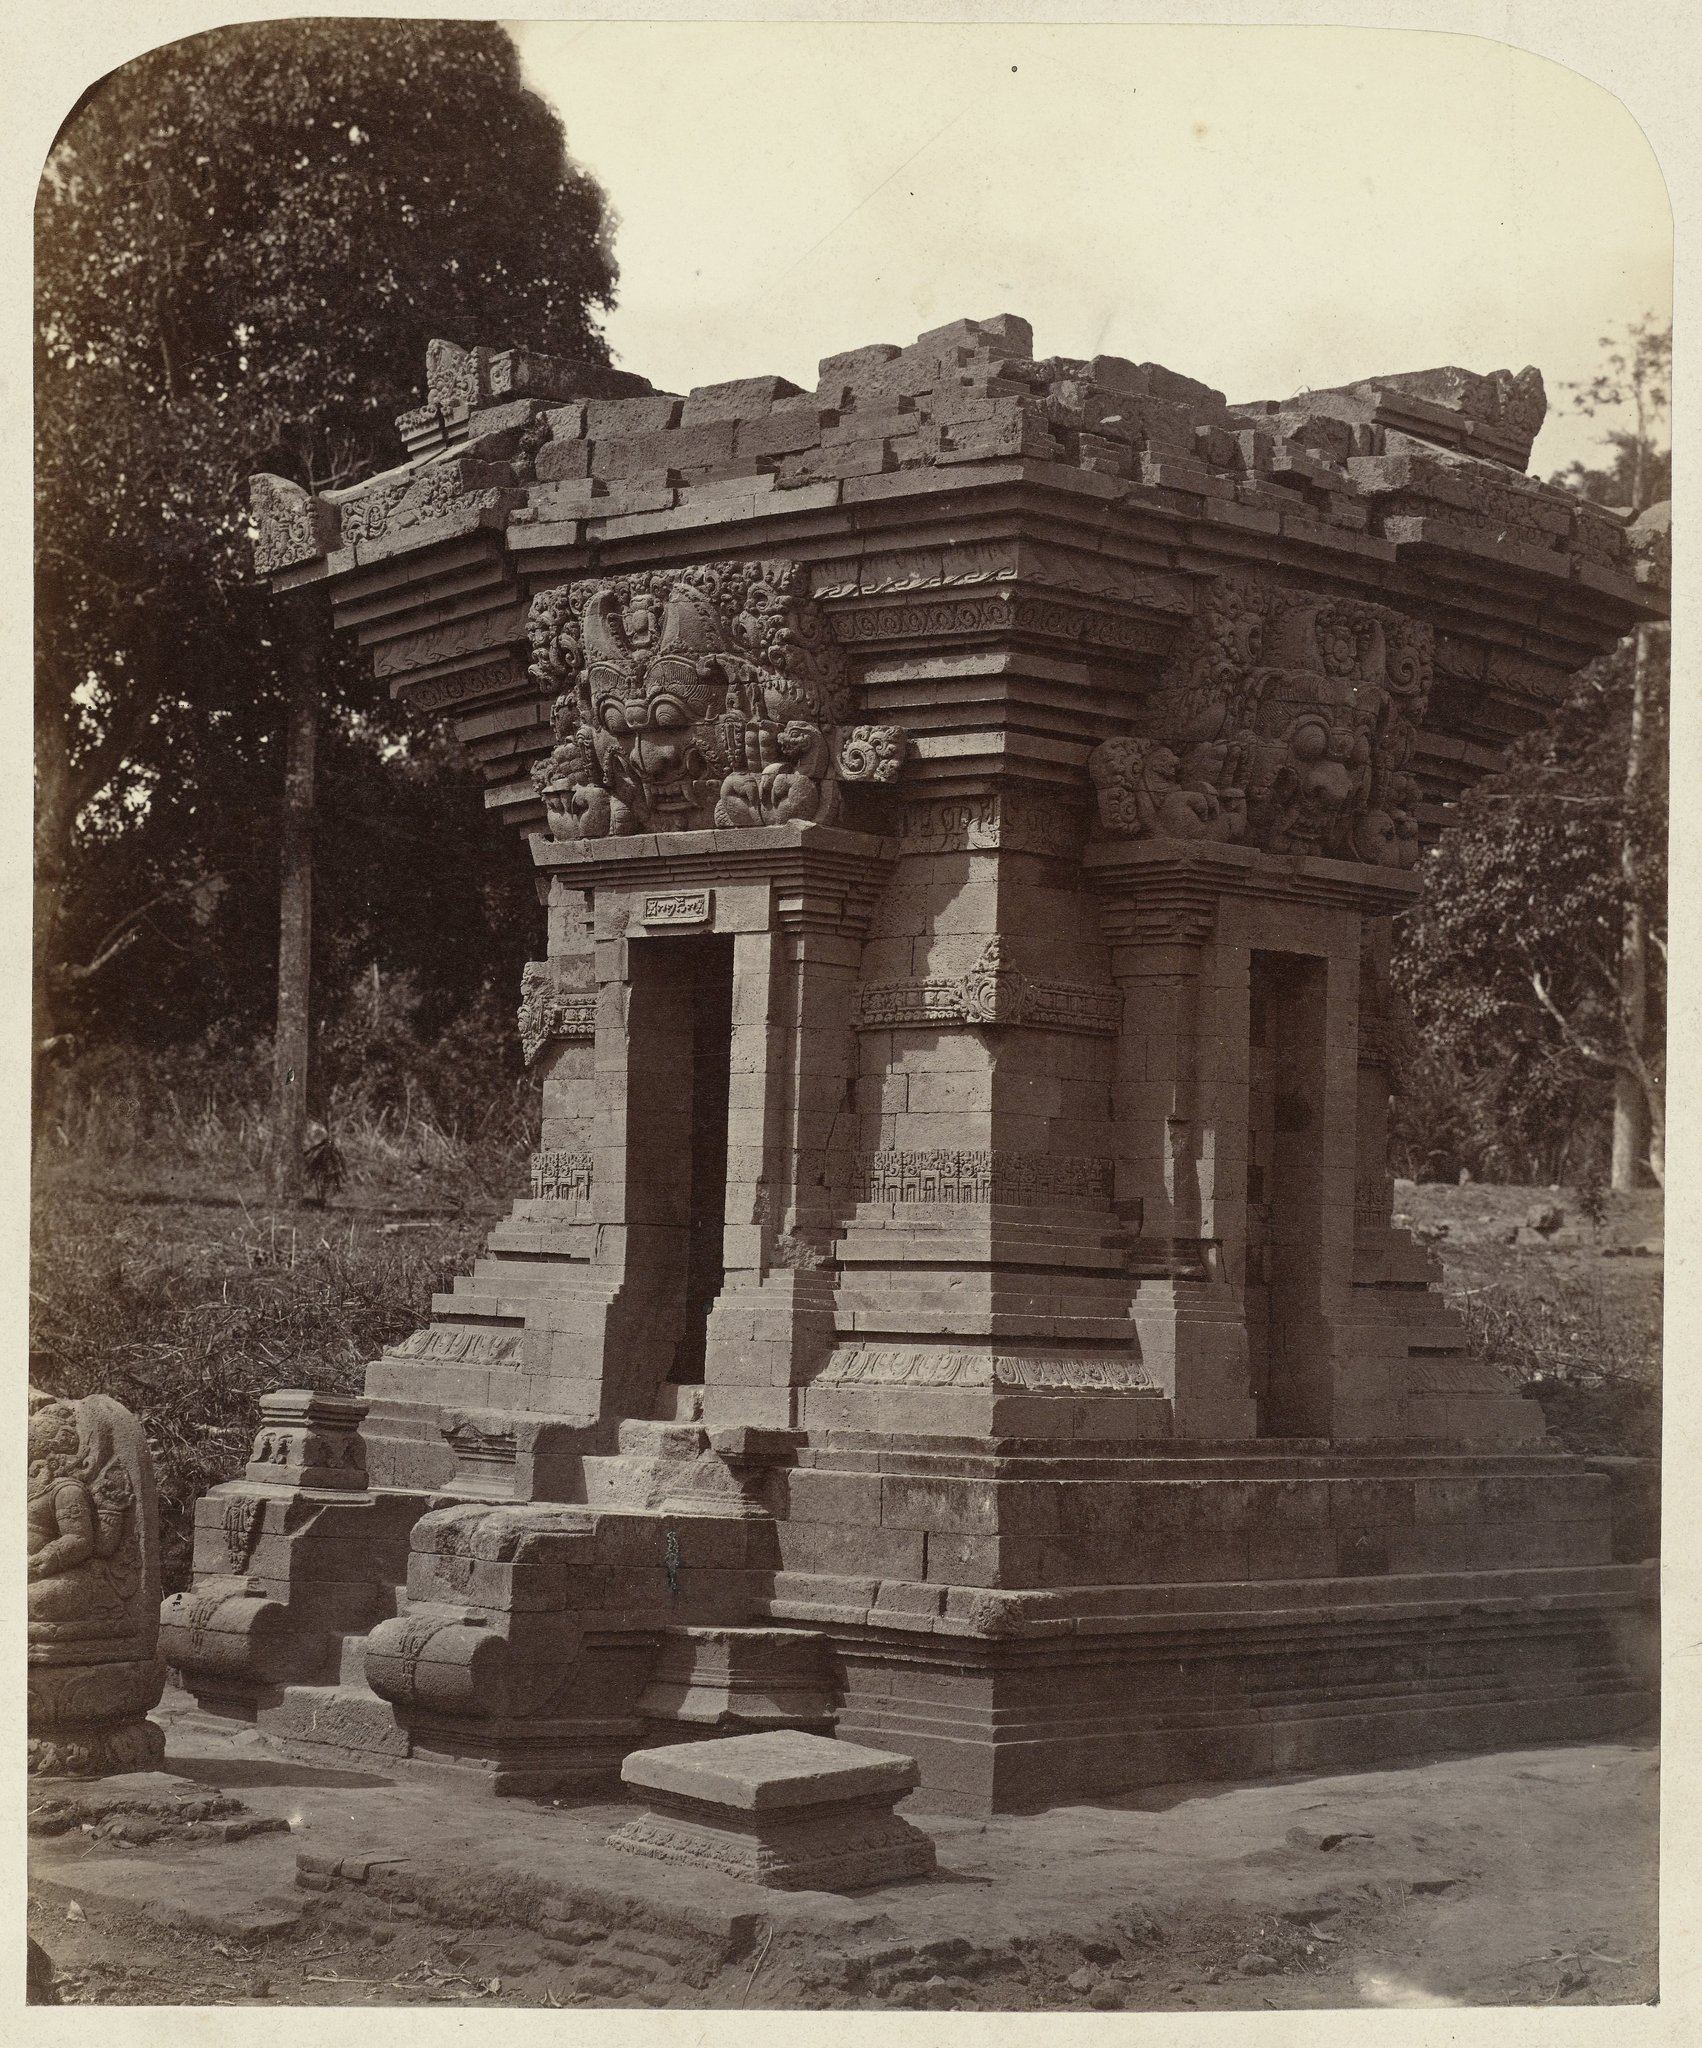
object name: photograph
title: Kleine bijtempel met boven de ingang een Kala hoofd op Candi Panataran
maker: isidore kinsbergen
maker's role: fotograaf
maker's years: 1821-1905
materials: cardboard, paper, photographic support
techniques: albumen print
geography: java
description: Candi Panataran (Temple Complex), Dated Temple; inscribed subsidairy temple with kala head, from south-west. Panataran, Blitar district, East Java province 1323-1347 AD.